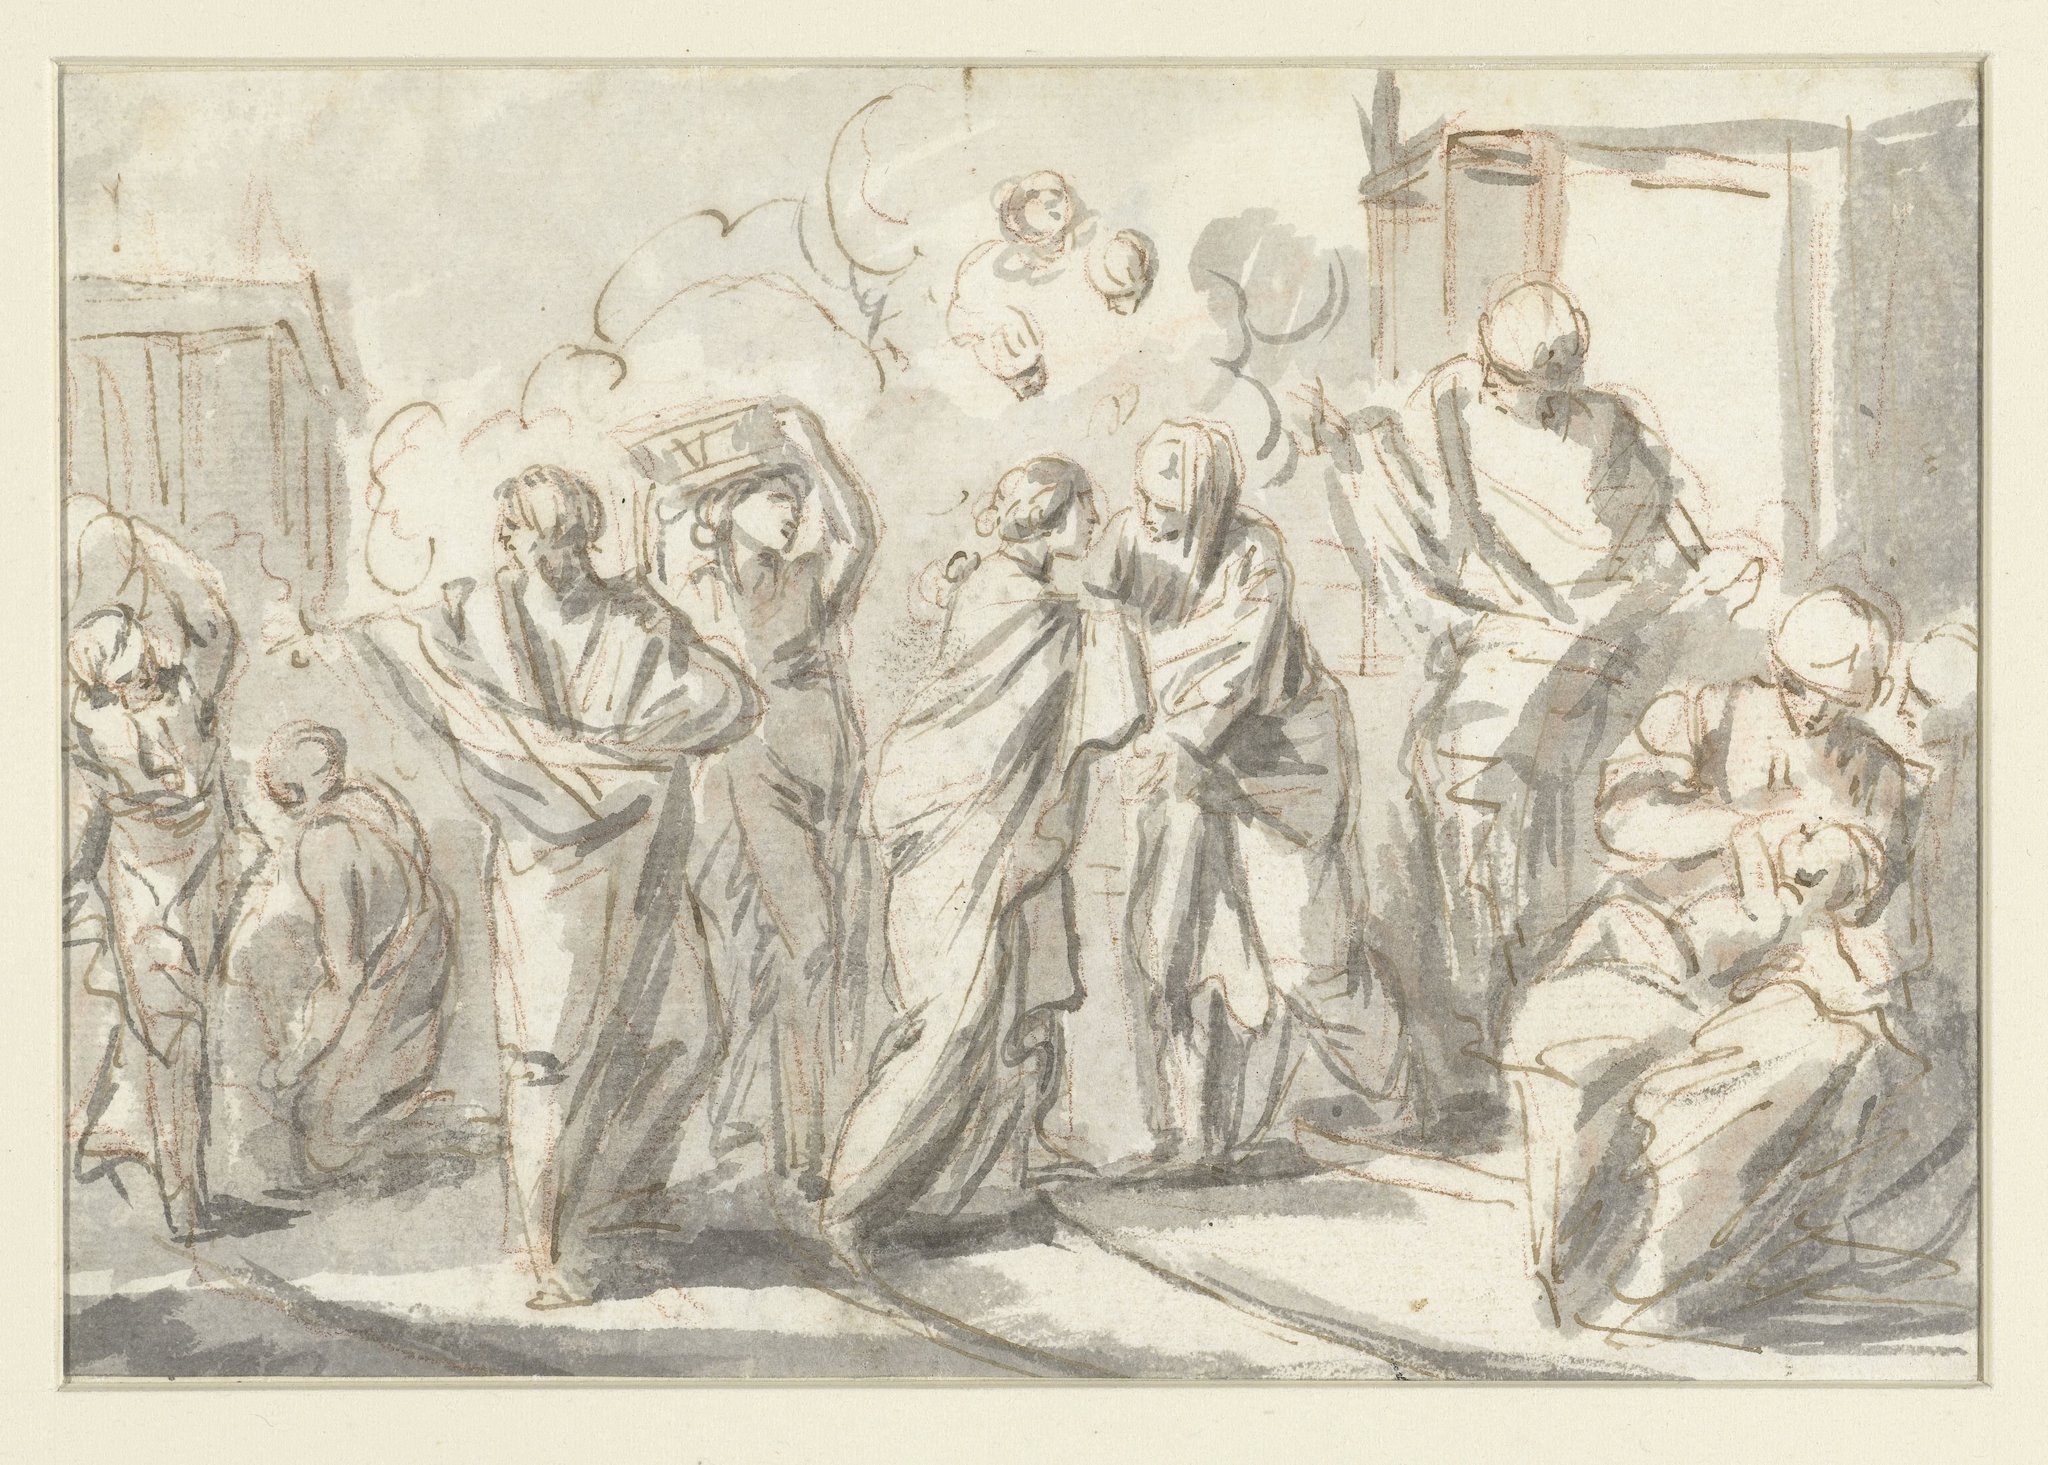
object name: drawing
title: Visitatie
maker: Anonymous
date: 1700-1800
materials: chalk, ink, paper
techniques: brush, pen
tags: visitation (possibly joseph and/or zacharias present) (luke 1:39-56)